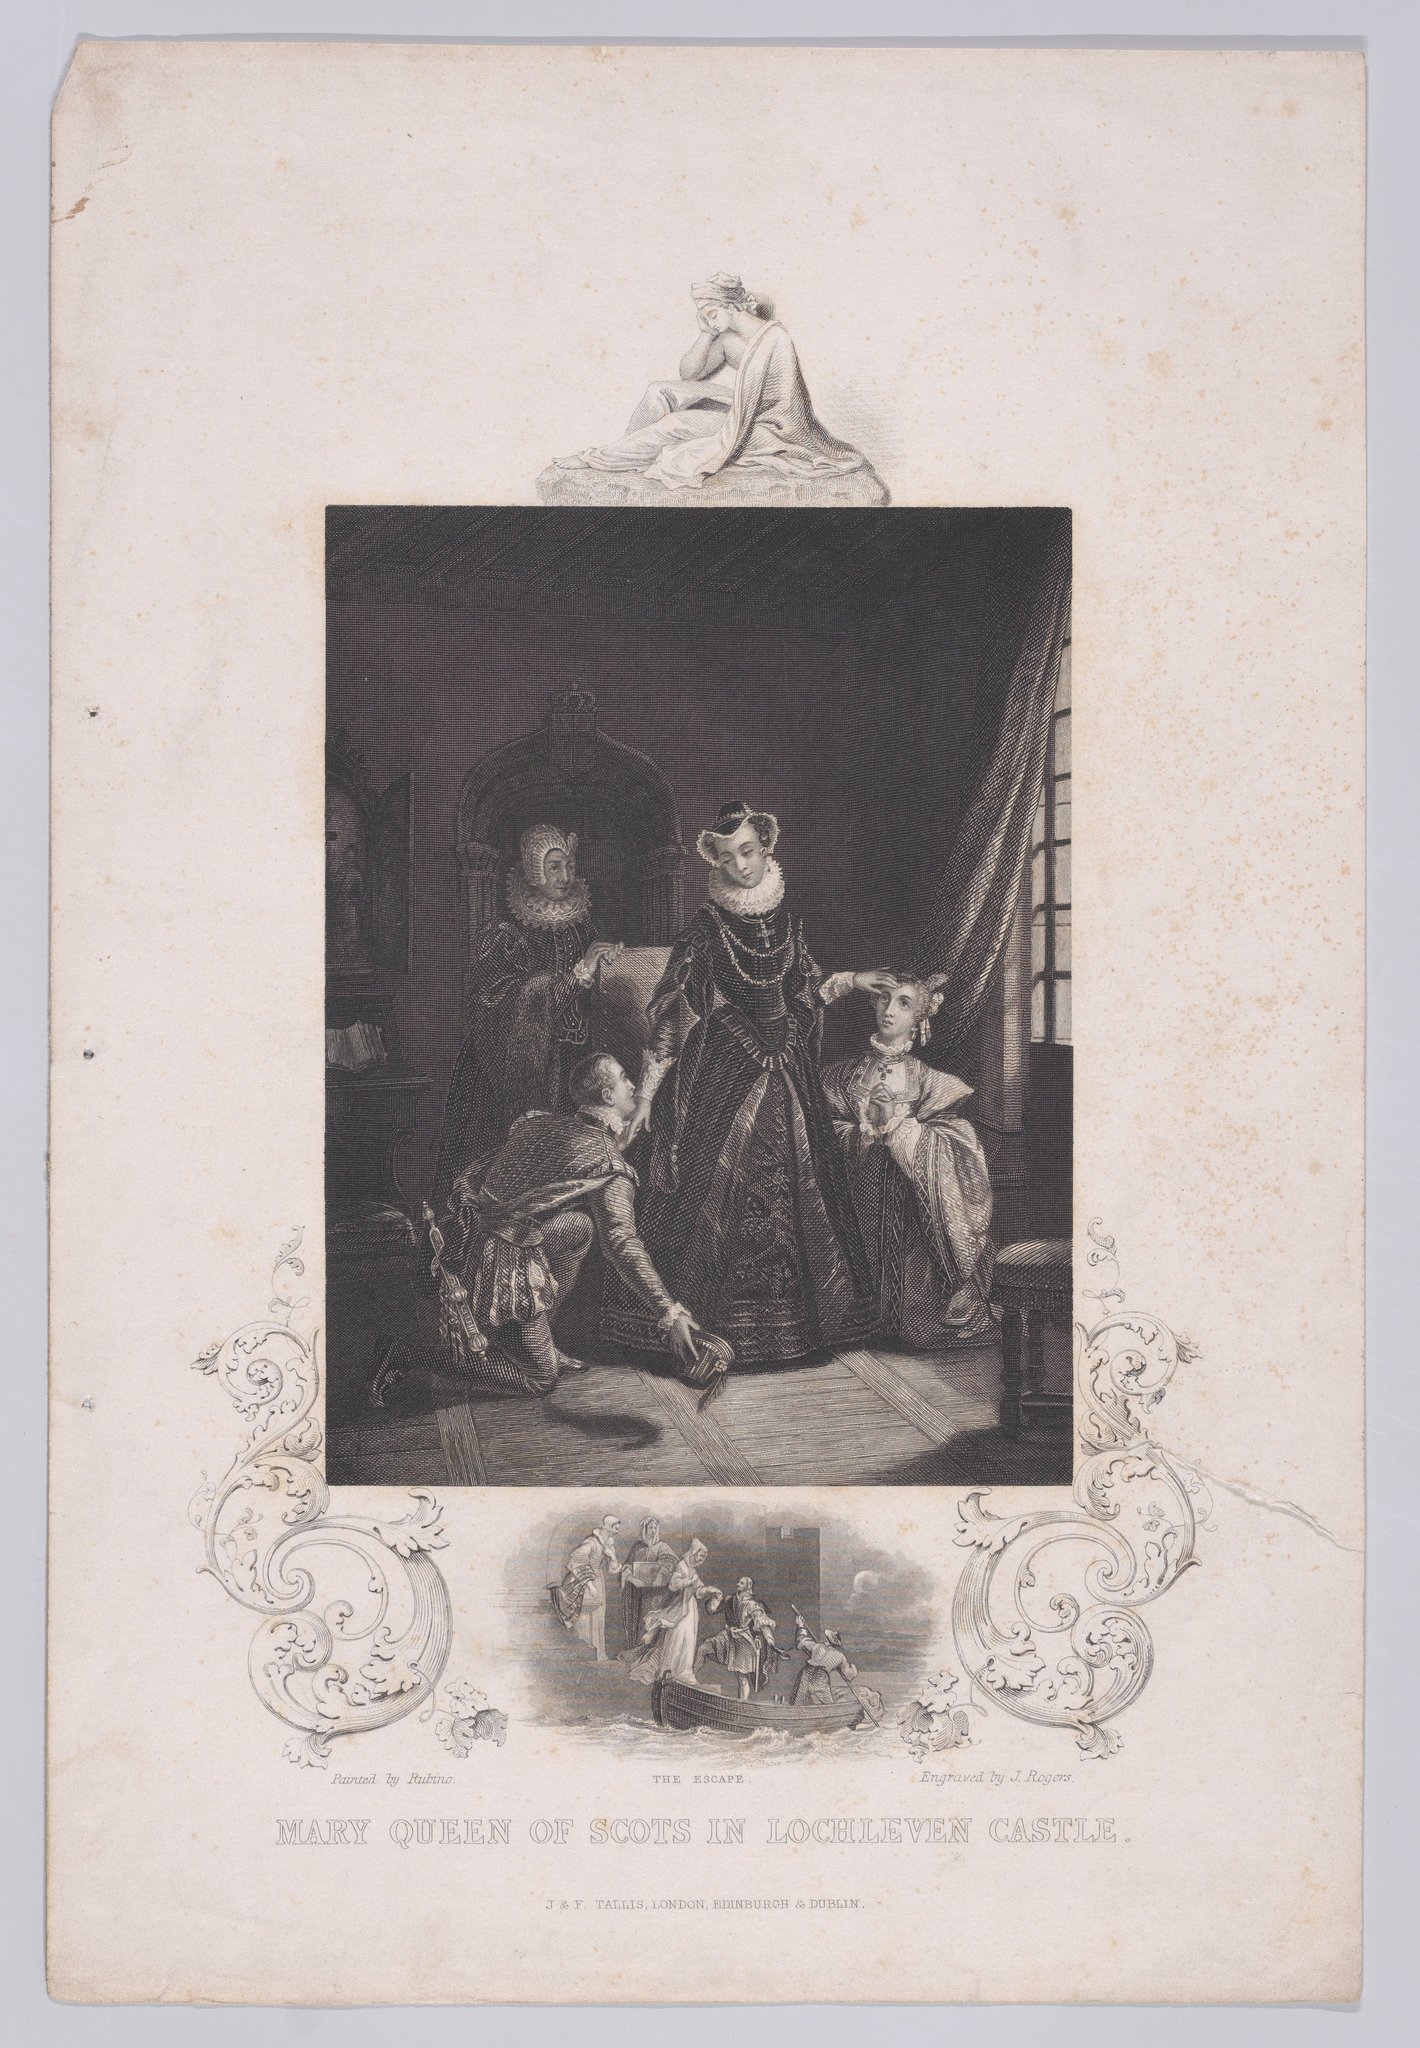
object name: print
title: Mary, Queen of Scots in Lochleven Castle, with a small scene of her escape from the castle below (from "The History of England")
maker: john rogers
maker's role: engraver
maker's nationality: british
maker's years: 1810-1860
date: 1830-1840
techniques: etching, stippling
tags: queens,men,women,mary queen of scots